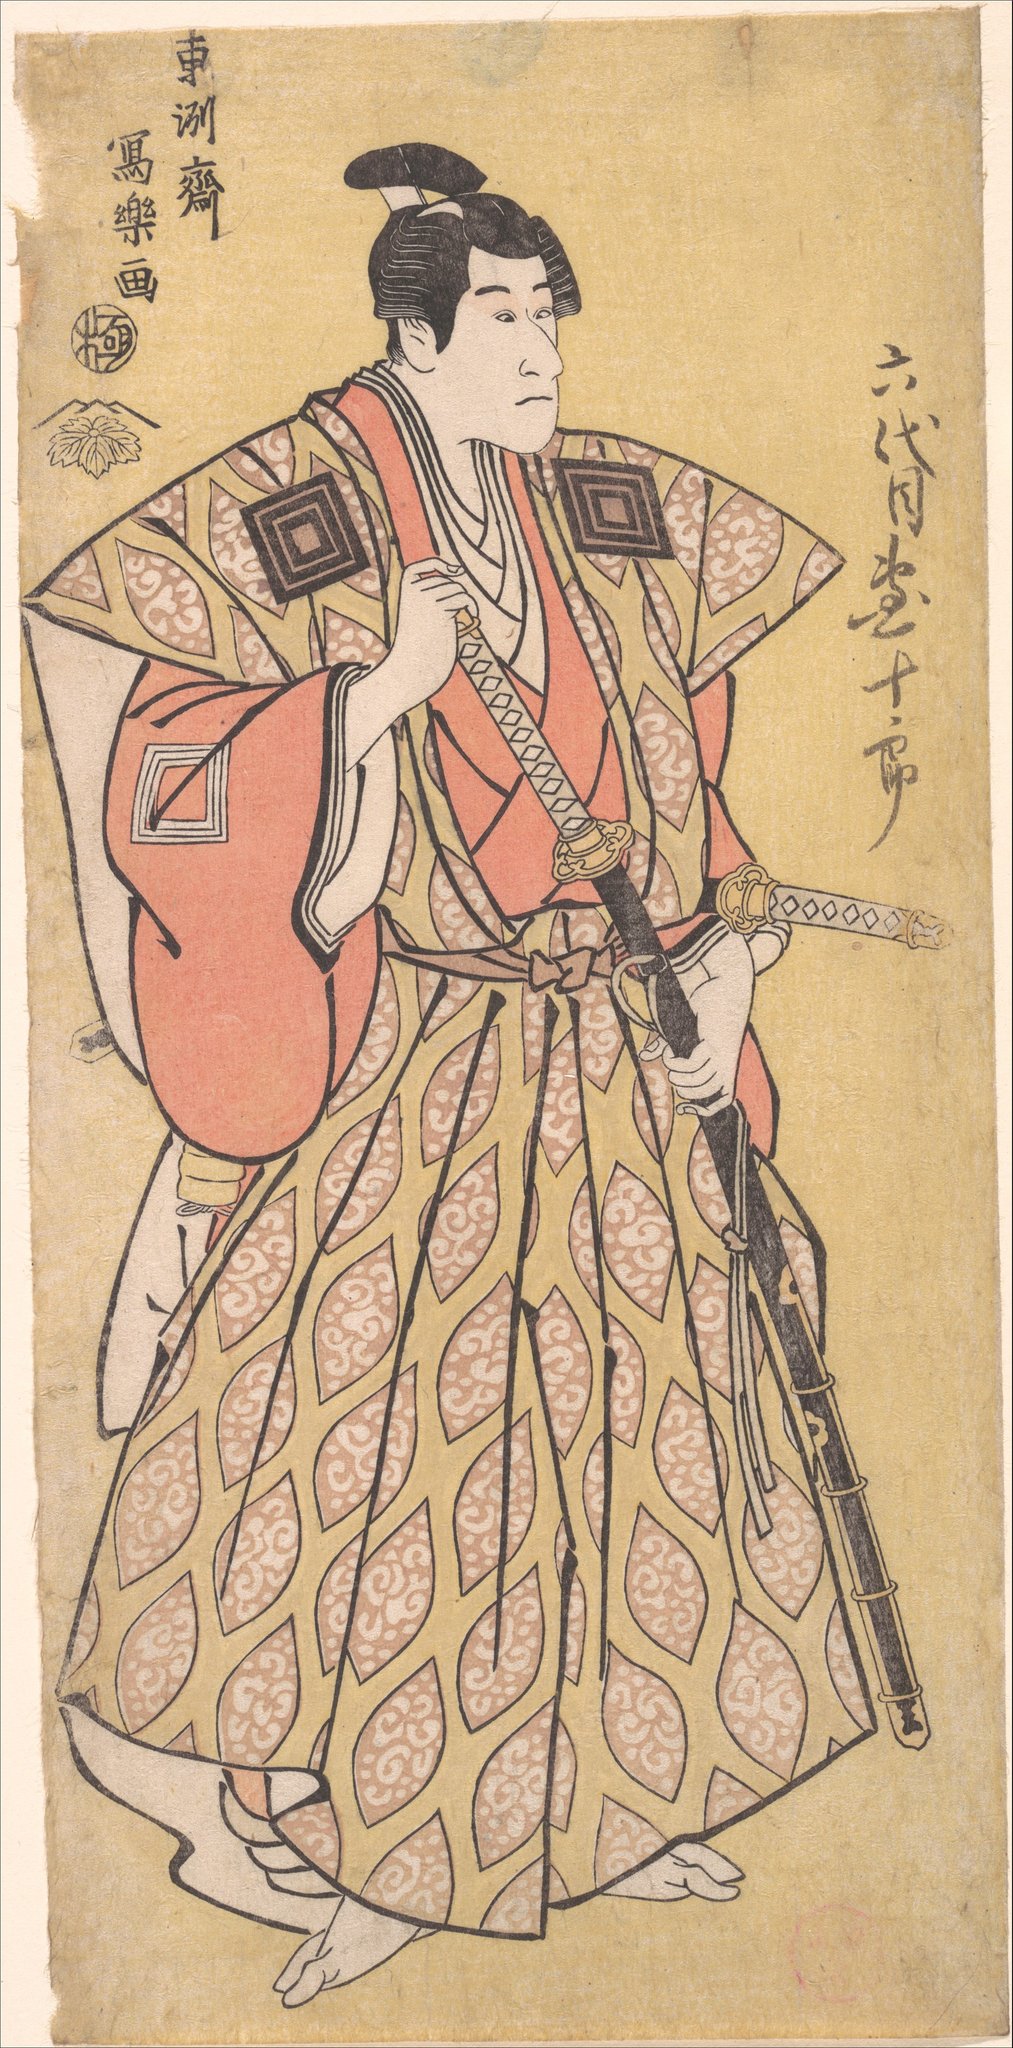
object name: print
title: Ichikawa Danjuro VI as Funa Bansaku,son of Fuwa Banzayemon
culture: japanese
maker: tōshūsai sharaku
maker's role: artist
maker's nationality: japanese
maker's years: 1794-1795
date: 1794-1795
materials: ink, paper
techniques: woodblock print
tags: swords,men,actors